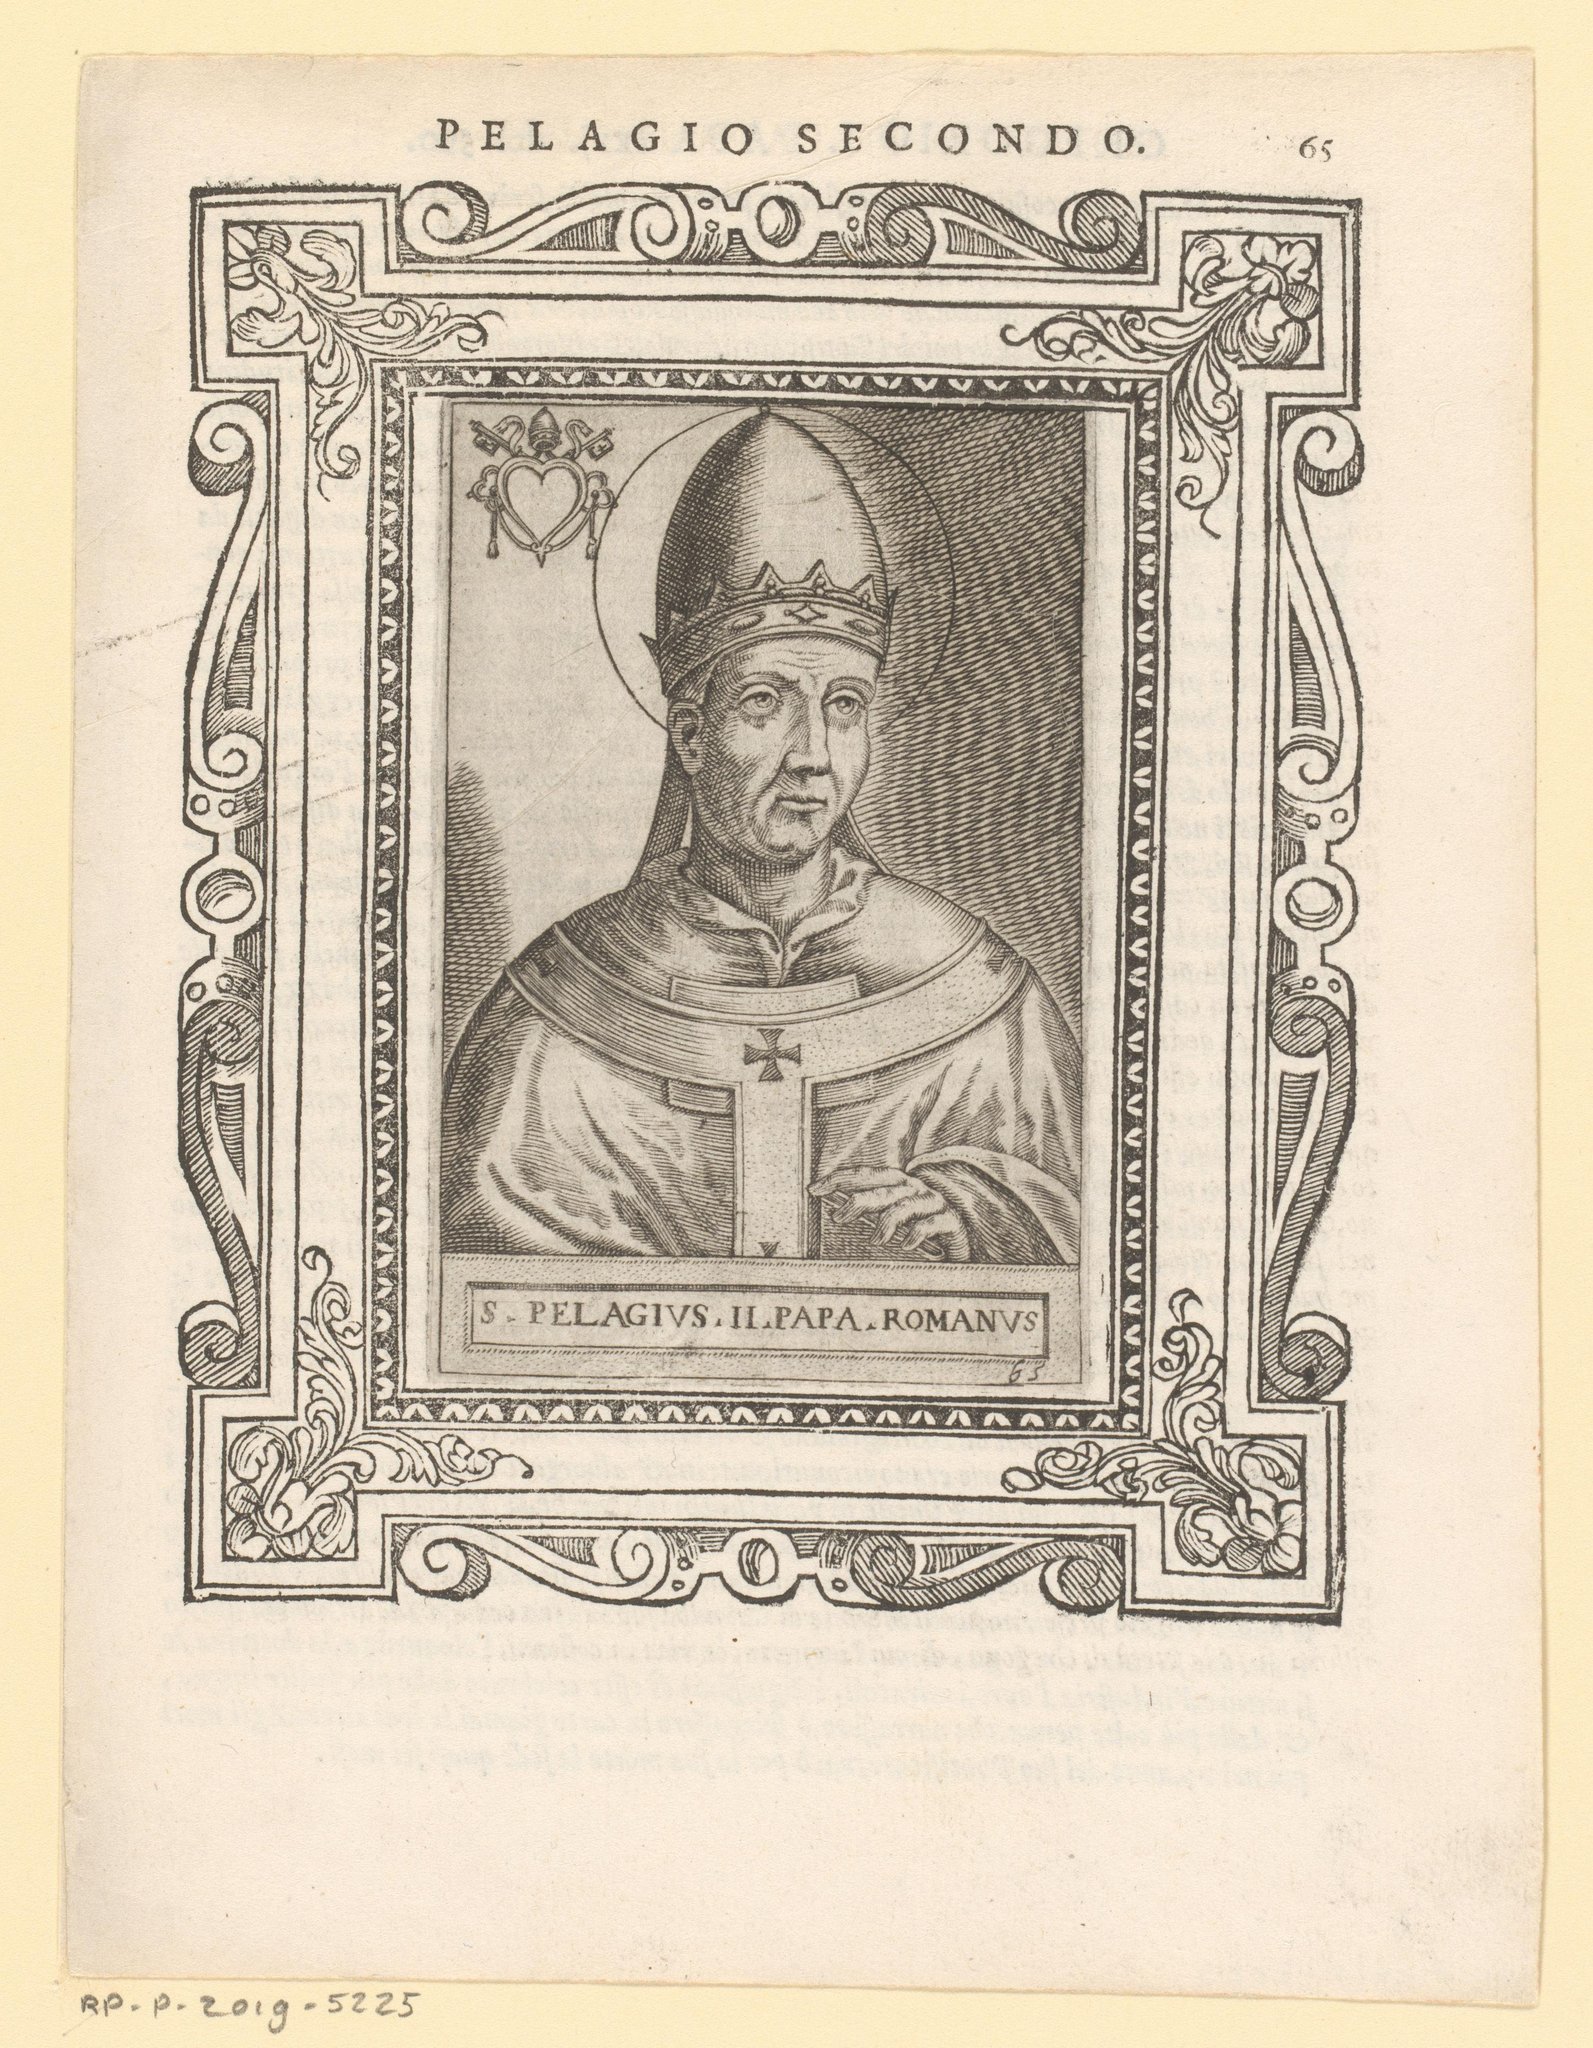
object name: print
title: Portret van paus Pelagius II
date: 1587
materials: paper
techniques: engraving, letterpress printing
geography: rome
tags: historical persons, pope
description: Prent uit: Ciccarelli, Antonio. Le vite de Pontefici di Antonio Ciccarelli (...). Rome: Domenico Basa, 1587. Prent voor het eerst verschenen in: Cavalieri, Giovanni Battista de'. Pontificum romanorum effigies (...). Rome: Domenico Basa en Francesco Zanetti, 1580. Prent ook gebruikt in latere publicaties.